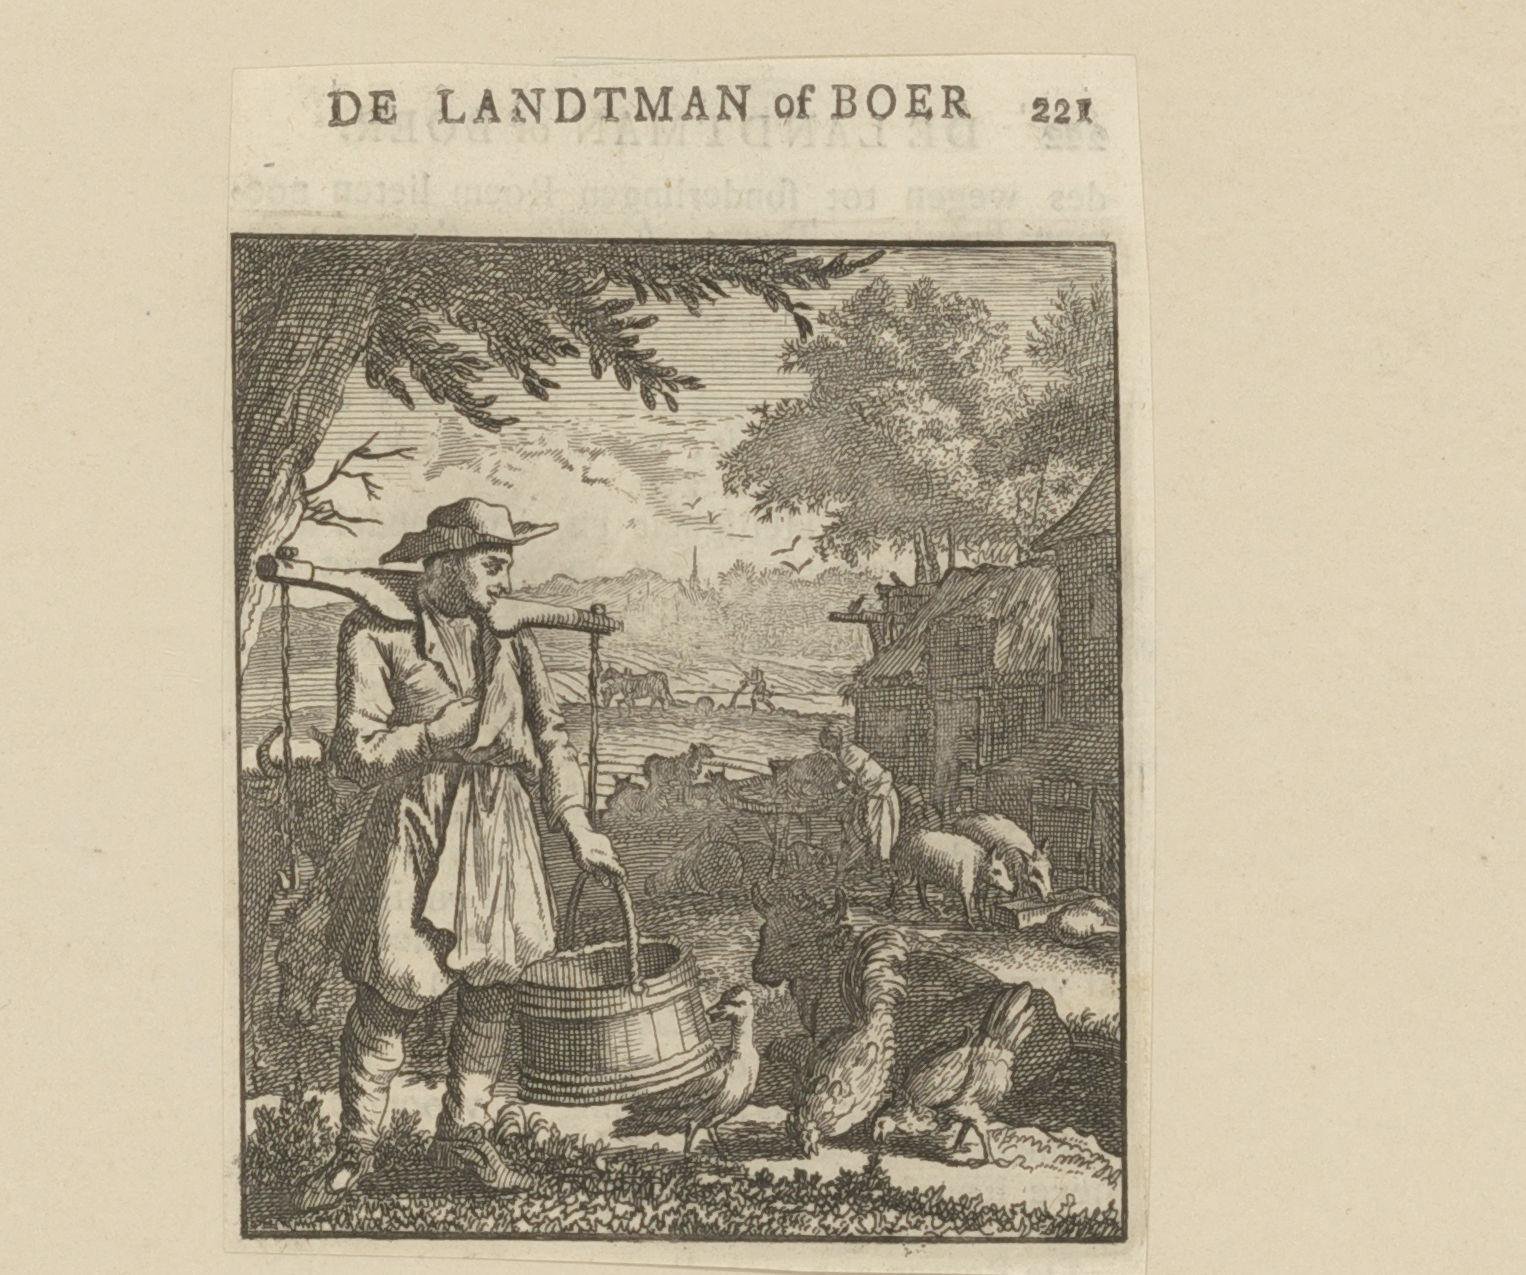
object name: print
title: De Landtman of Boer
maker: Anonymous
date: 1719-1759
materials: paper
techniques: etching, letterpress printing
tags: cattle, farmers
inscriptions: collector's mark: Lugt 1641, stamp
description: Prent met andere letterzetting gebruikt in: St. Clara, Abraham van. Iets voor allen. [Vertaald door] J. le Long. Amsterdam: Janssoons van Waesberge, 1719, dl. 2. En in: St. Clara, Abraham van. Iets voor allen. [Vertaald door] J. le Long. Amsterdam: Jan Roman de Jonge, 1741, dl. 2. En in: St. Clara, Abraham van. Iets voor allen. [Vertaald door] J. le Long. Amsterdam: Jan Roman, 1759, dl. 2. Huidige prent uit een andere editie. Naar een prent van: Jan Luyken.